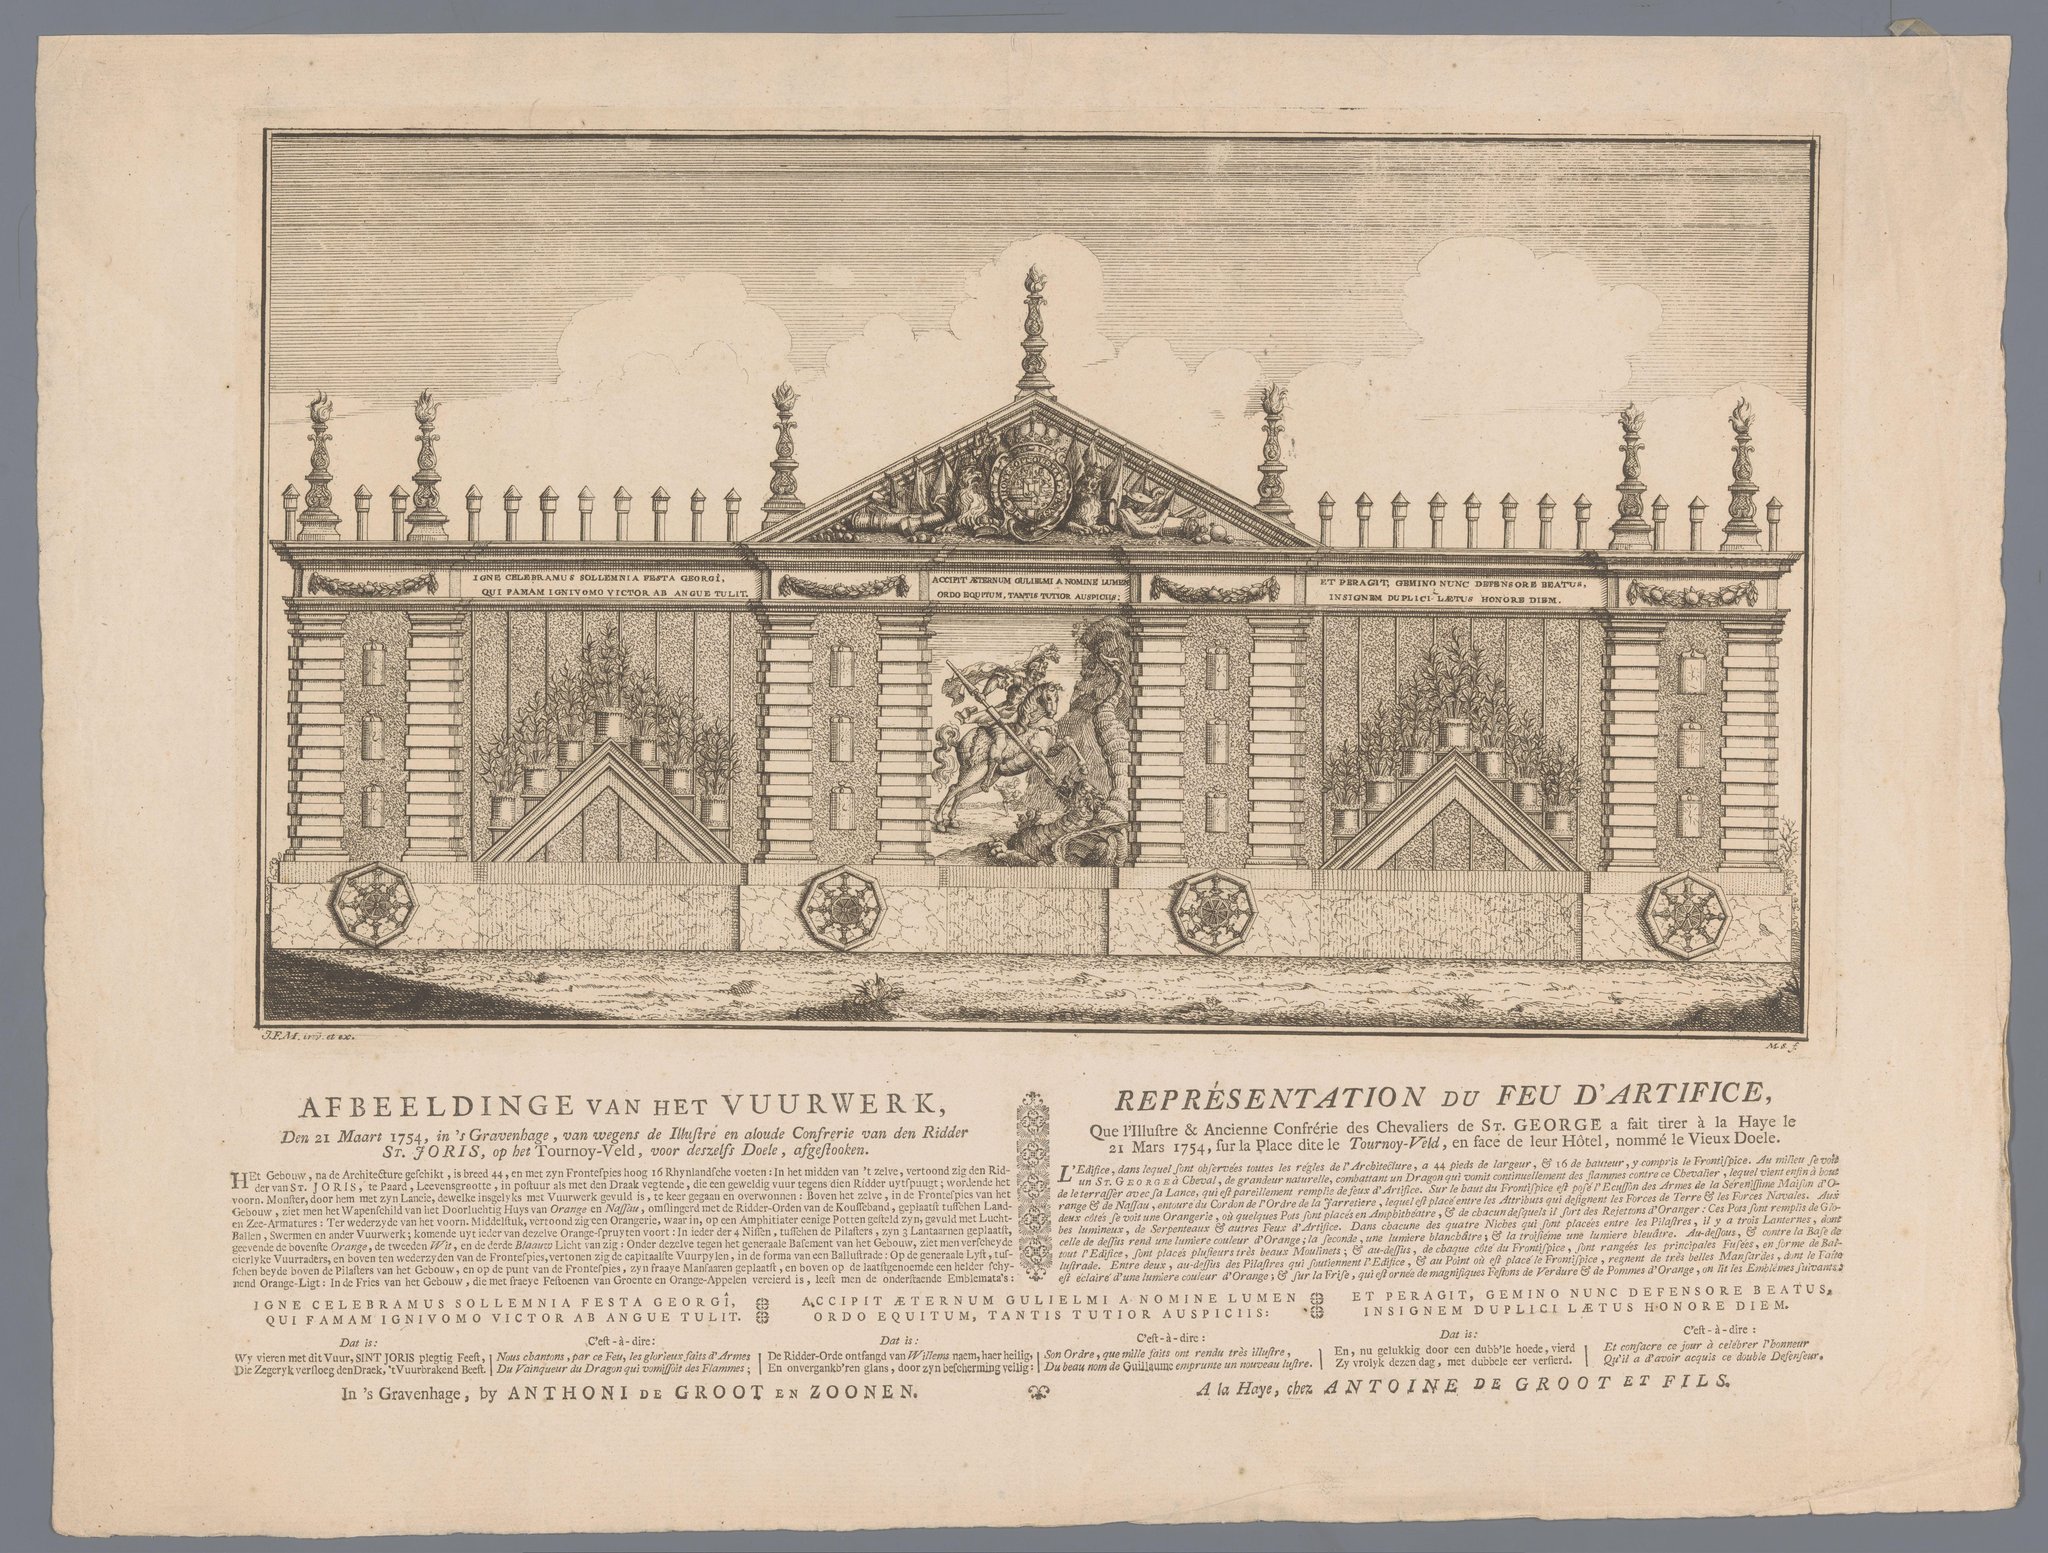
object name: print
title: Stellage voor het vuurwerk afgestoken bij verheffing van Willem V tot Ridder van St. Joris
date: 1754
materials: paper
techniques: engraving, etching, letterpress printing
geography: the hague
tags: the hague, william v (prince of orange), knighthood order, bonfire, fire-works